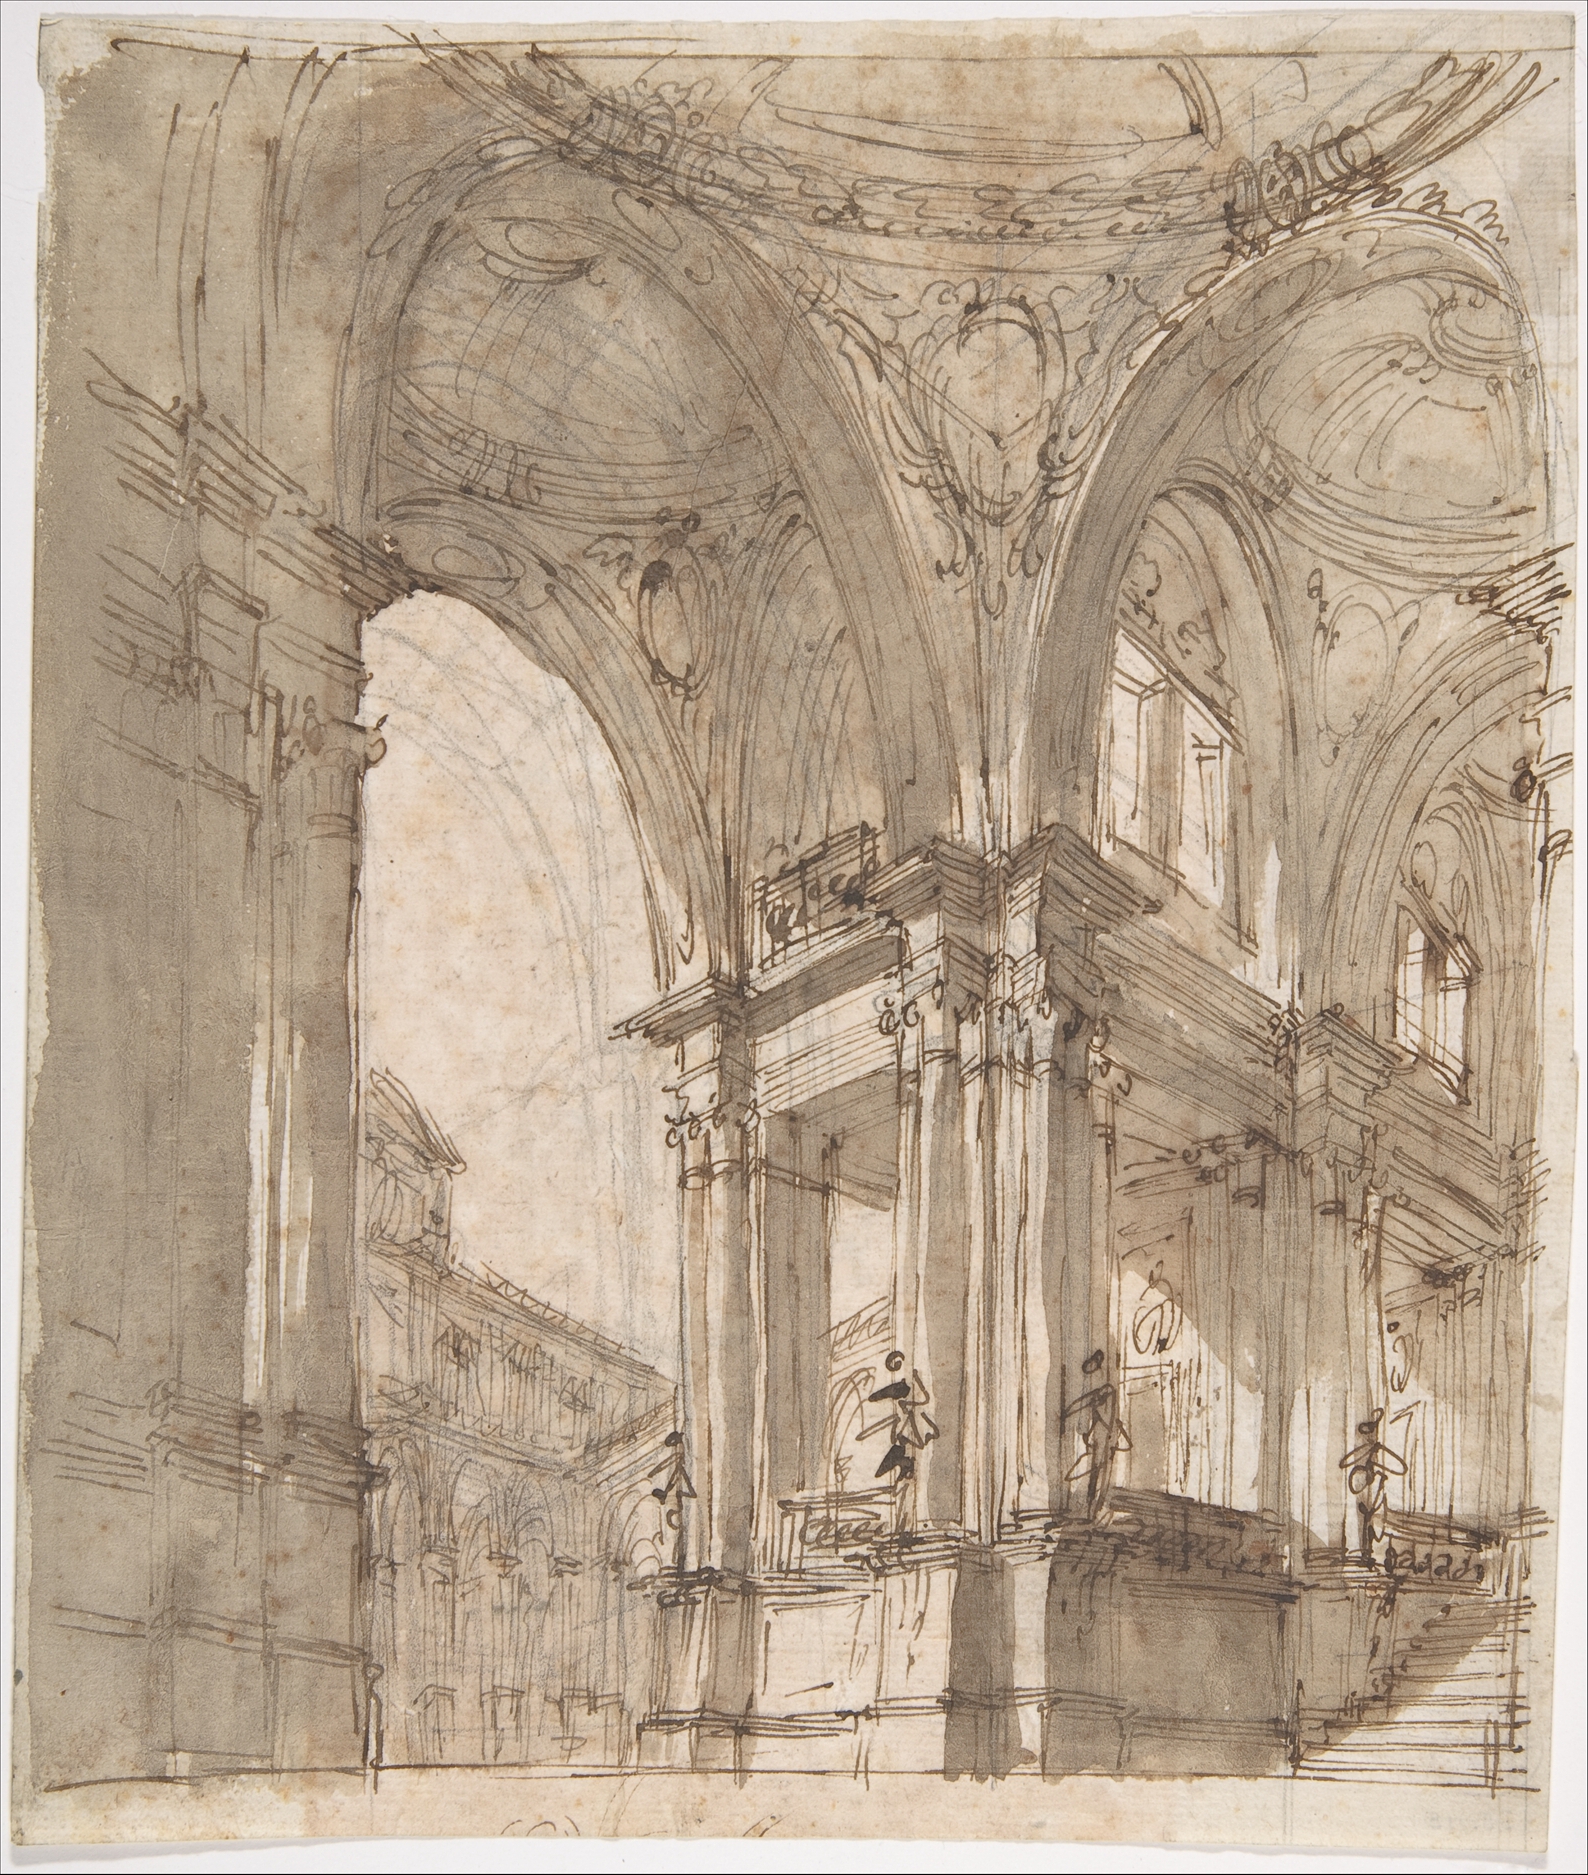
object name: drawing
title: Architectural Study (recto); Separate Sheet with Architectural Drawing (verso)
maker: filippo juvarra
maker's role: artist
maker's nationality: italian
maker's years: 1678-1736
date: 1676-1736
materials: graphite, ink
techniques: brush, pen, wash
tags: architecture,arches